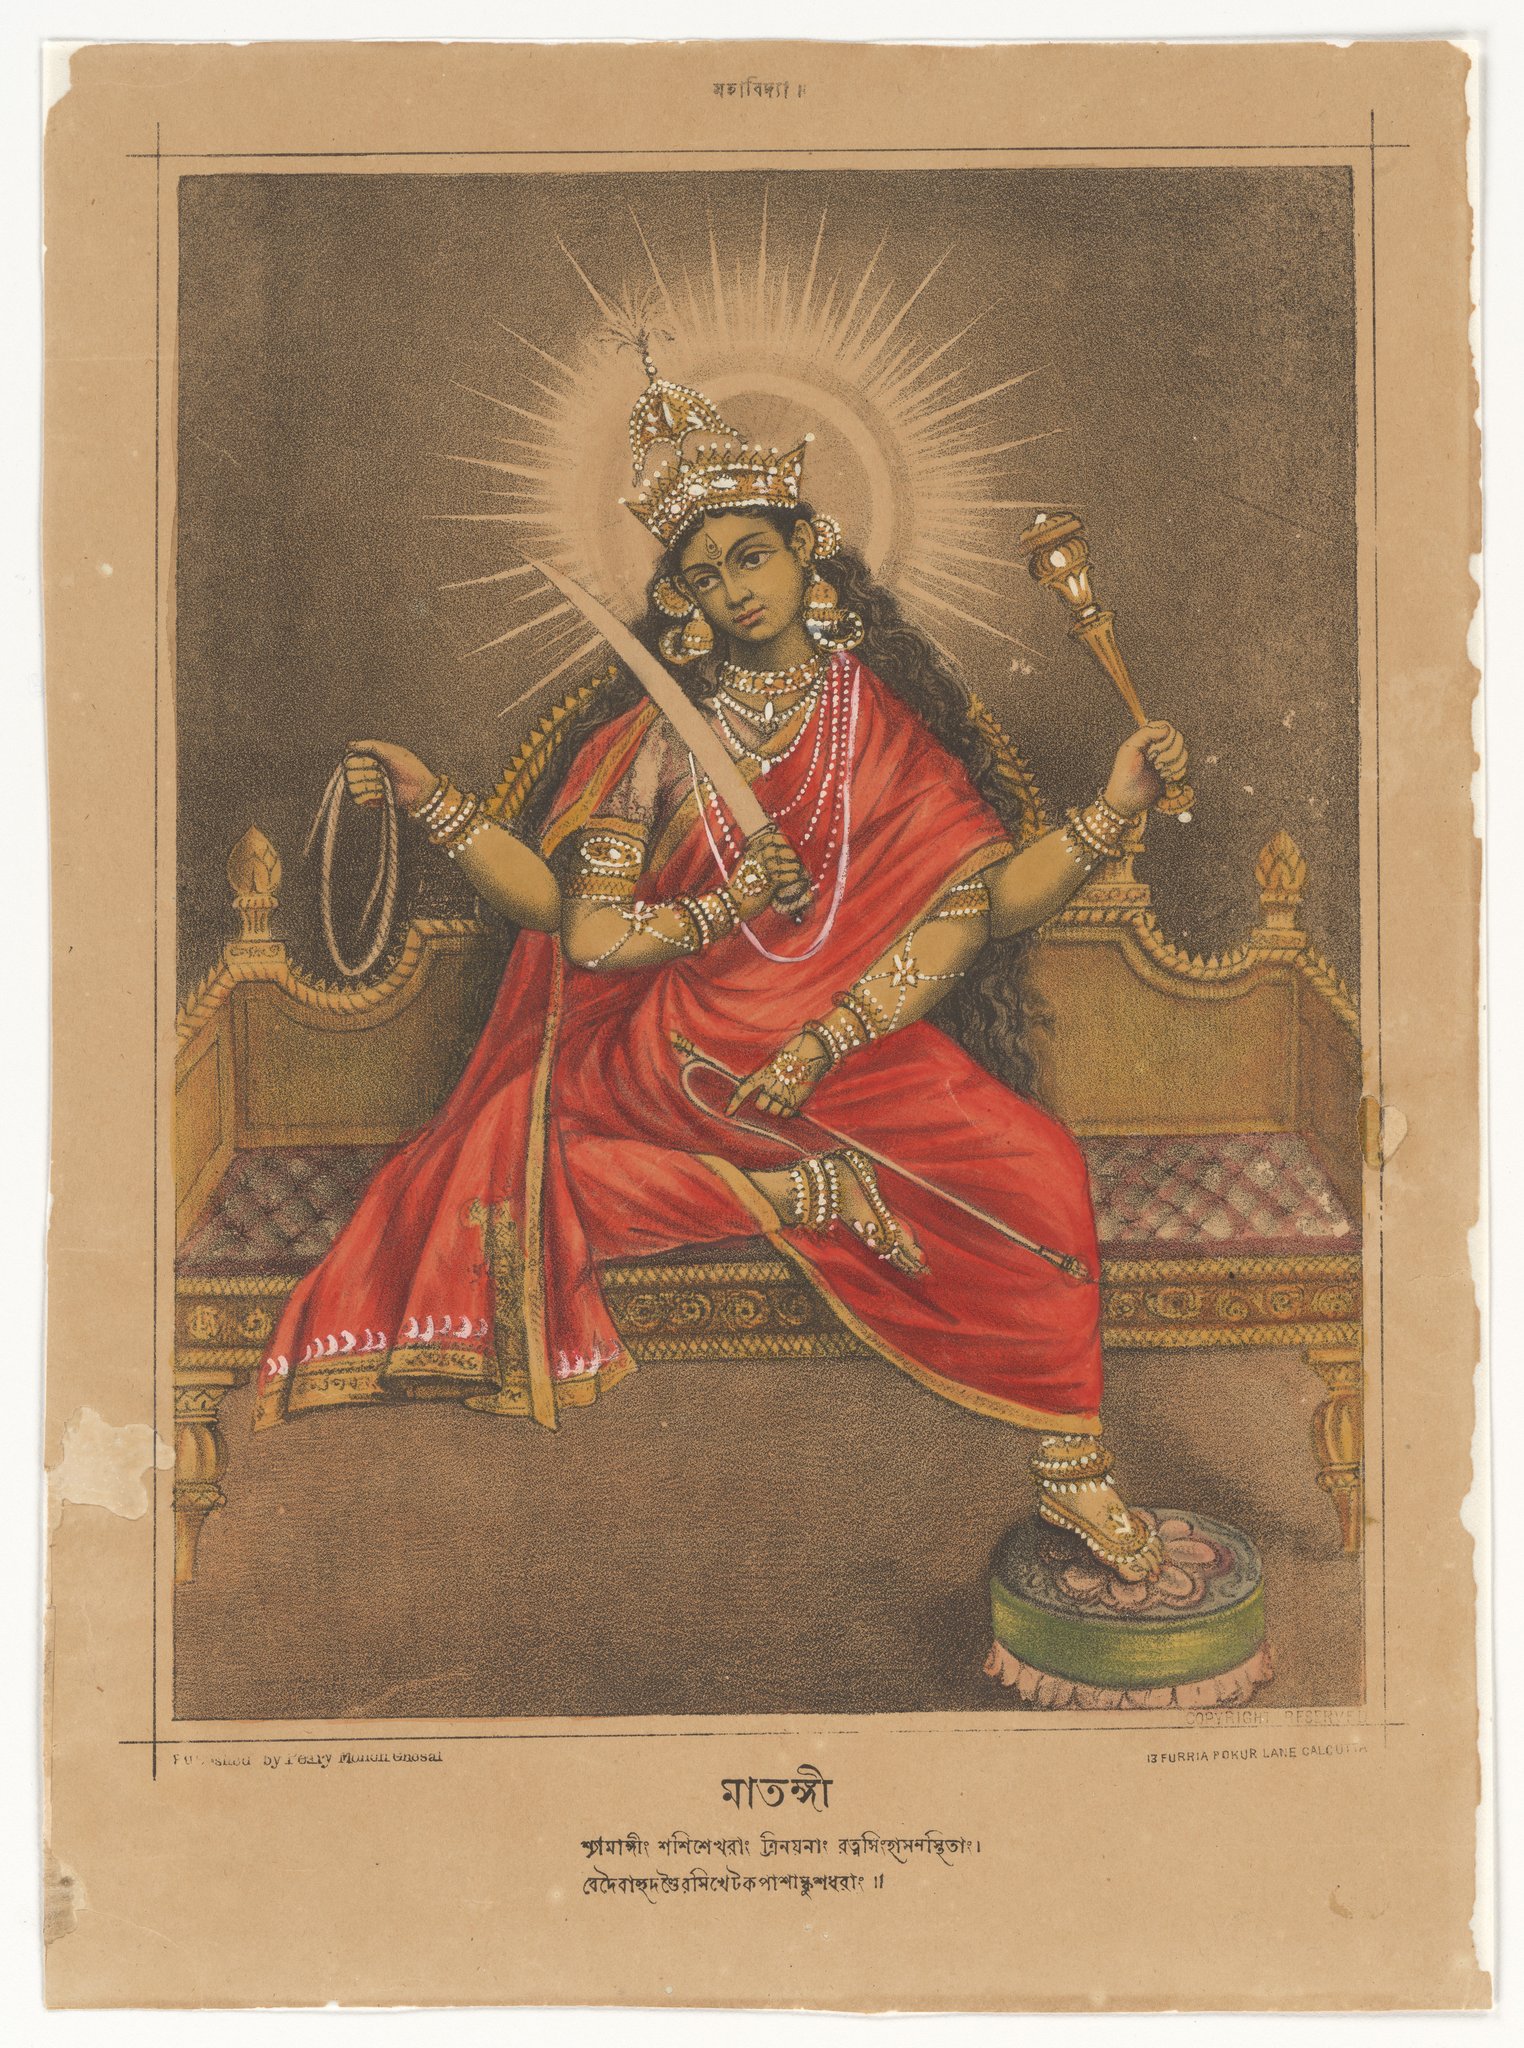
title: Goddess Matangi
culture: west bengali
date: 1880-1885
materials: glaze, watercolor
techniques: hand coloring, lithograph, printing